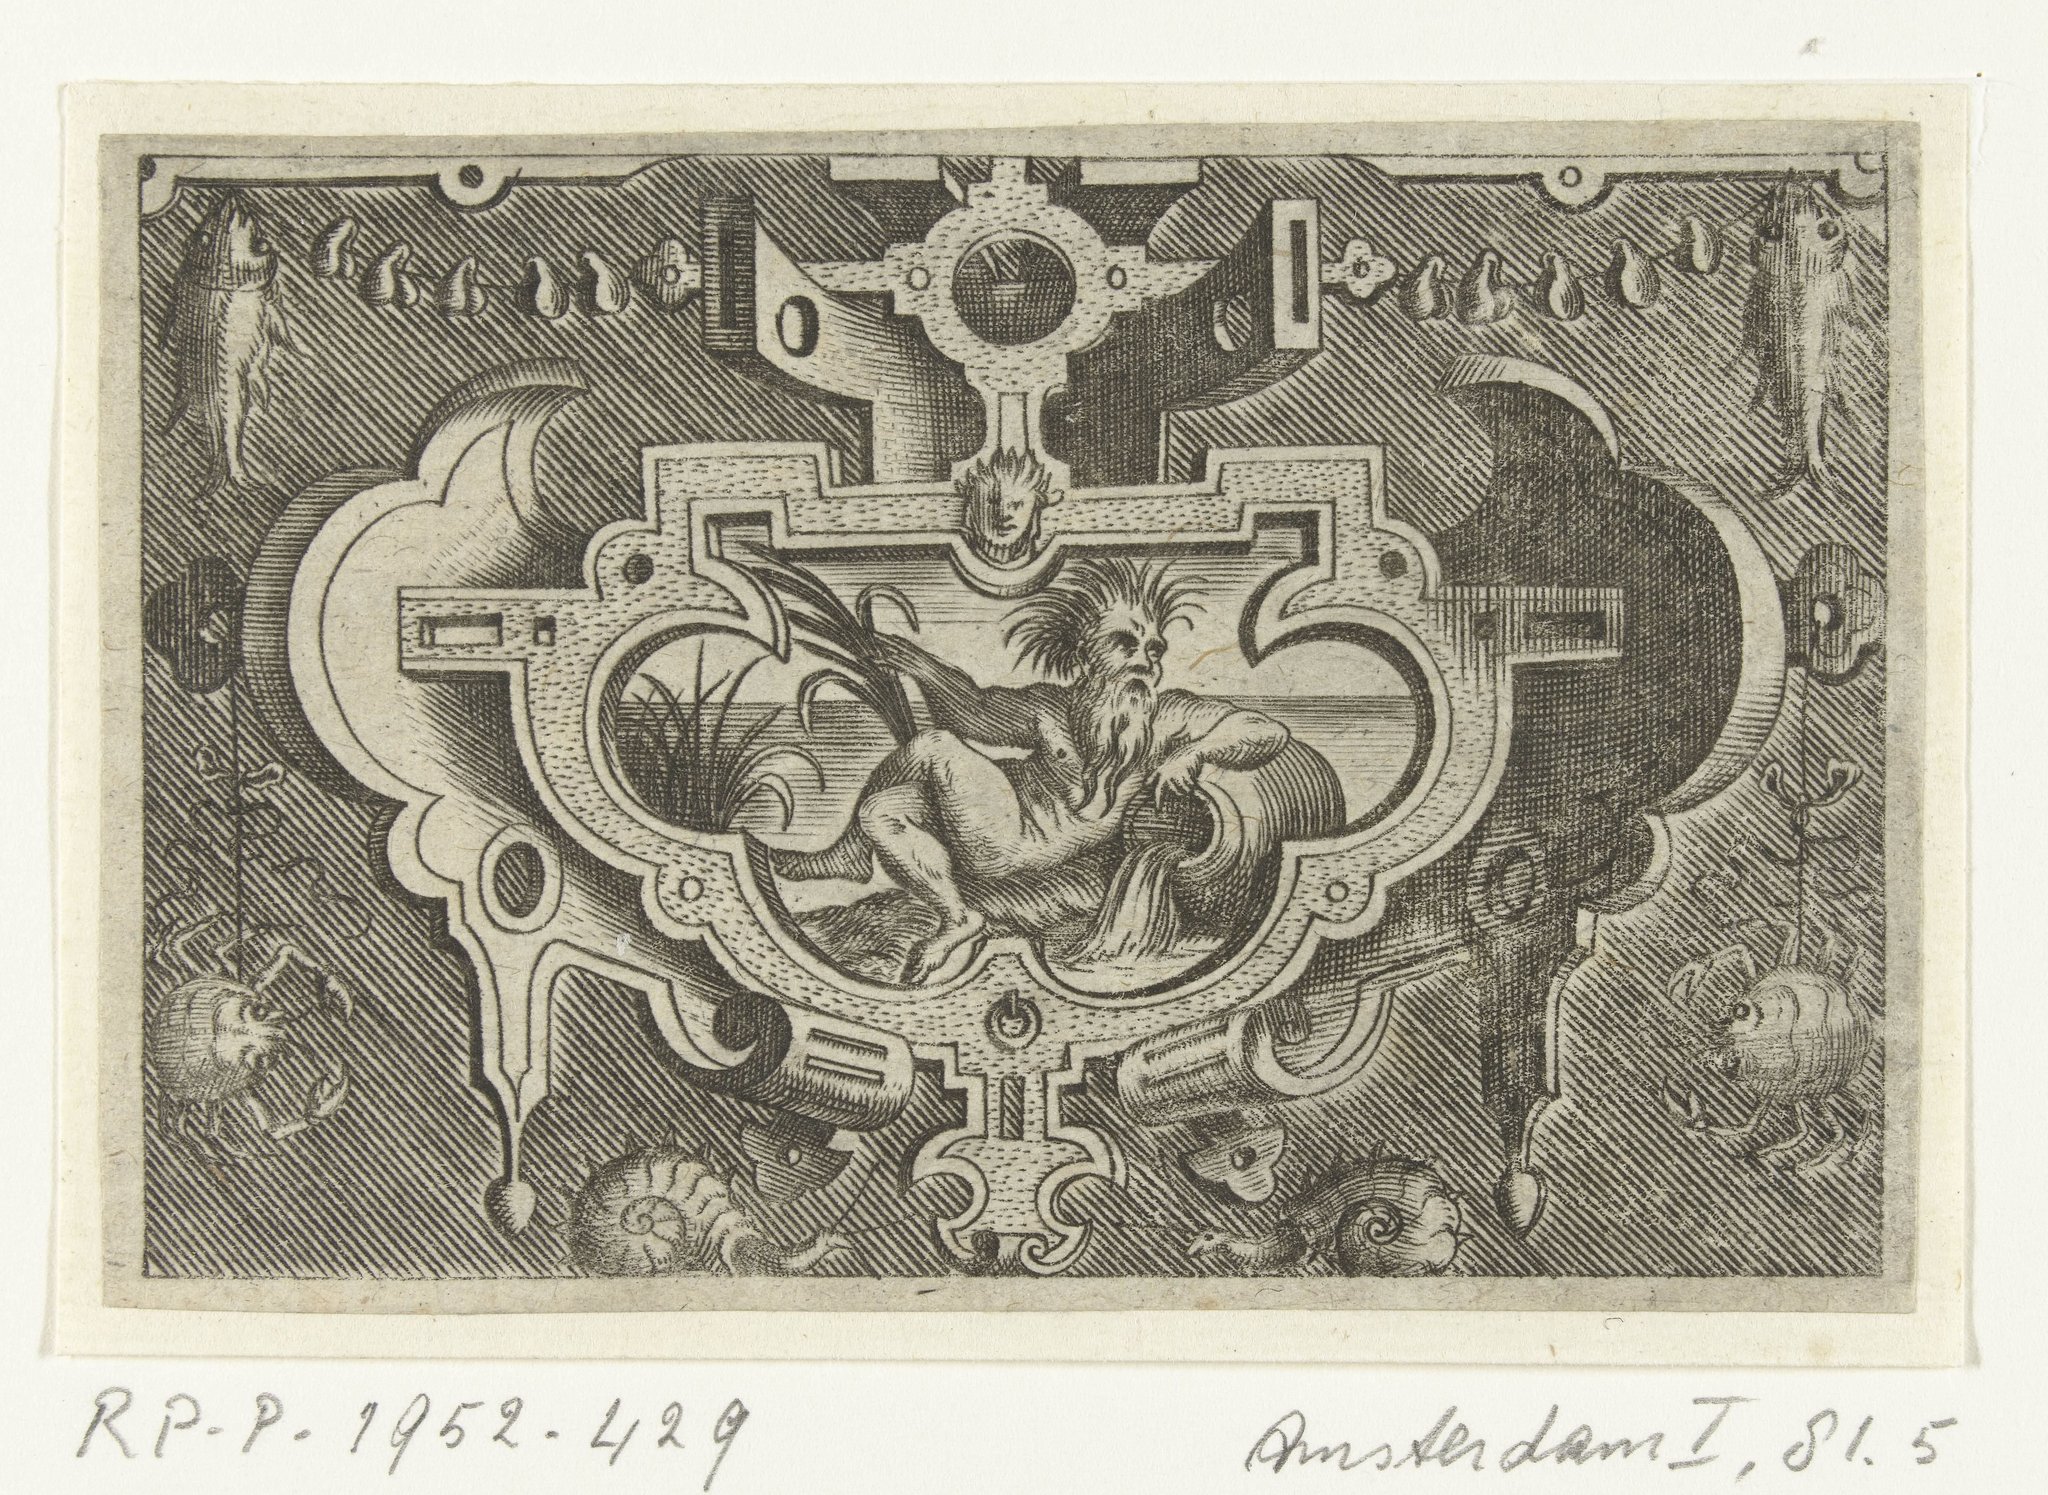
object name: print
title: Voorstellingen van de vier elementen: water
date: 1566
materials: paper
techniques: engraving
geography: netherlands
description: Blad uit serie bestaande uit een titelblad en 15 van de 16 bladen met cartouches met bijbelse en mythologische voorstellingen in een omlijsting van rolwerk en grotesken.